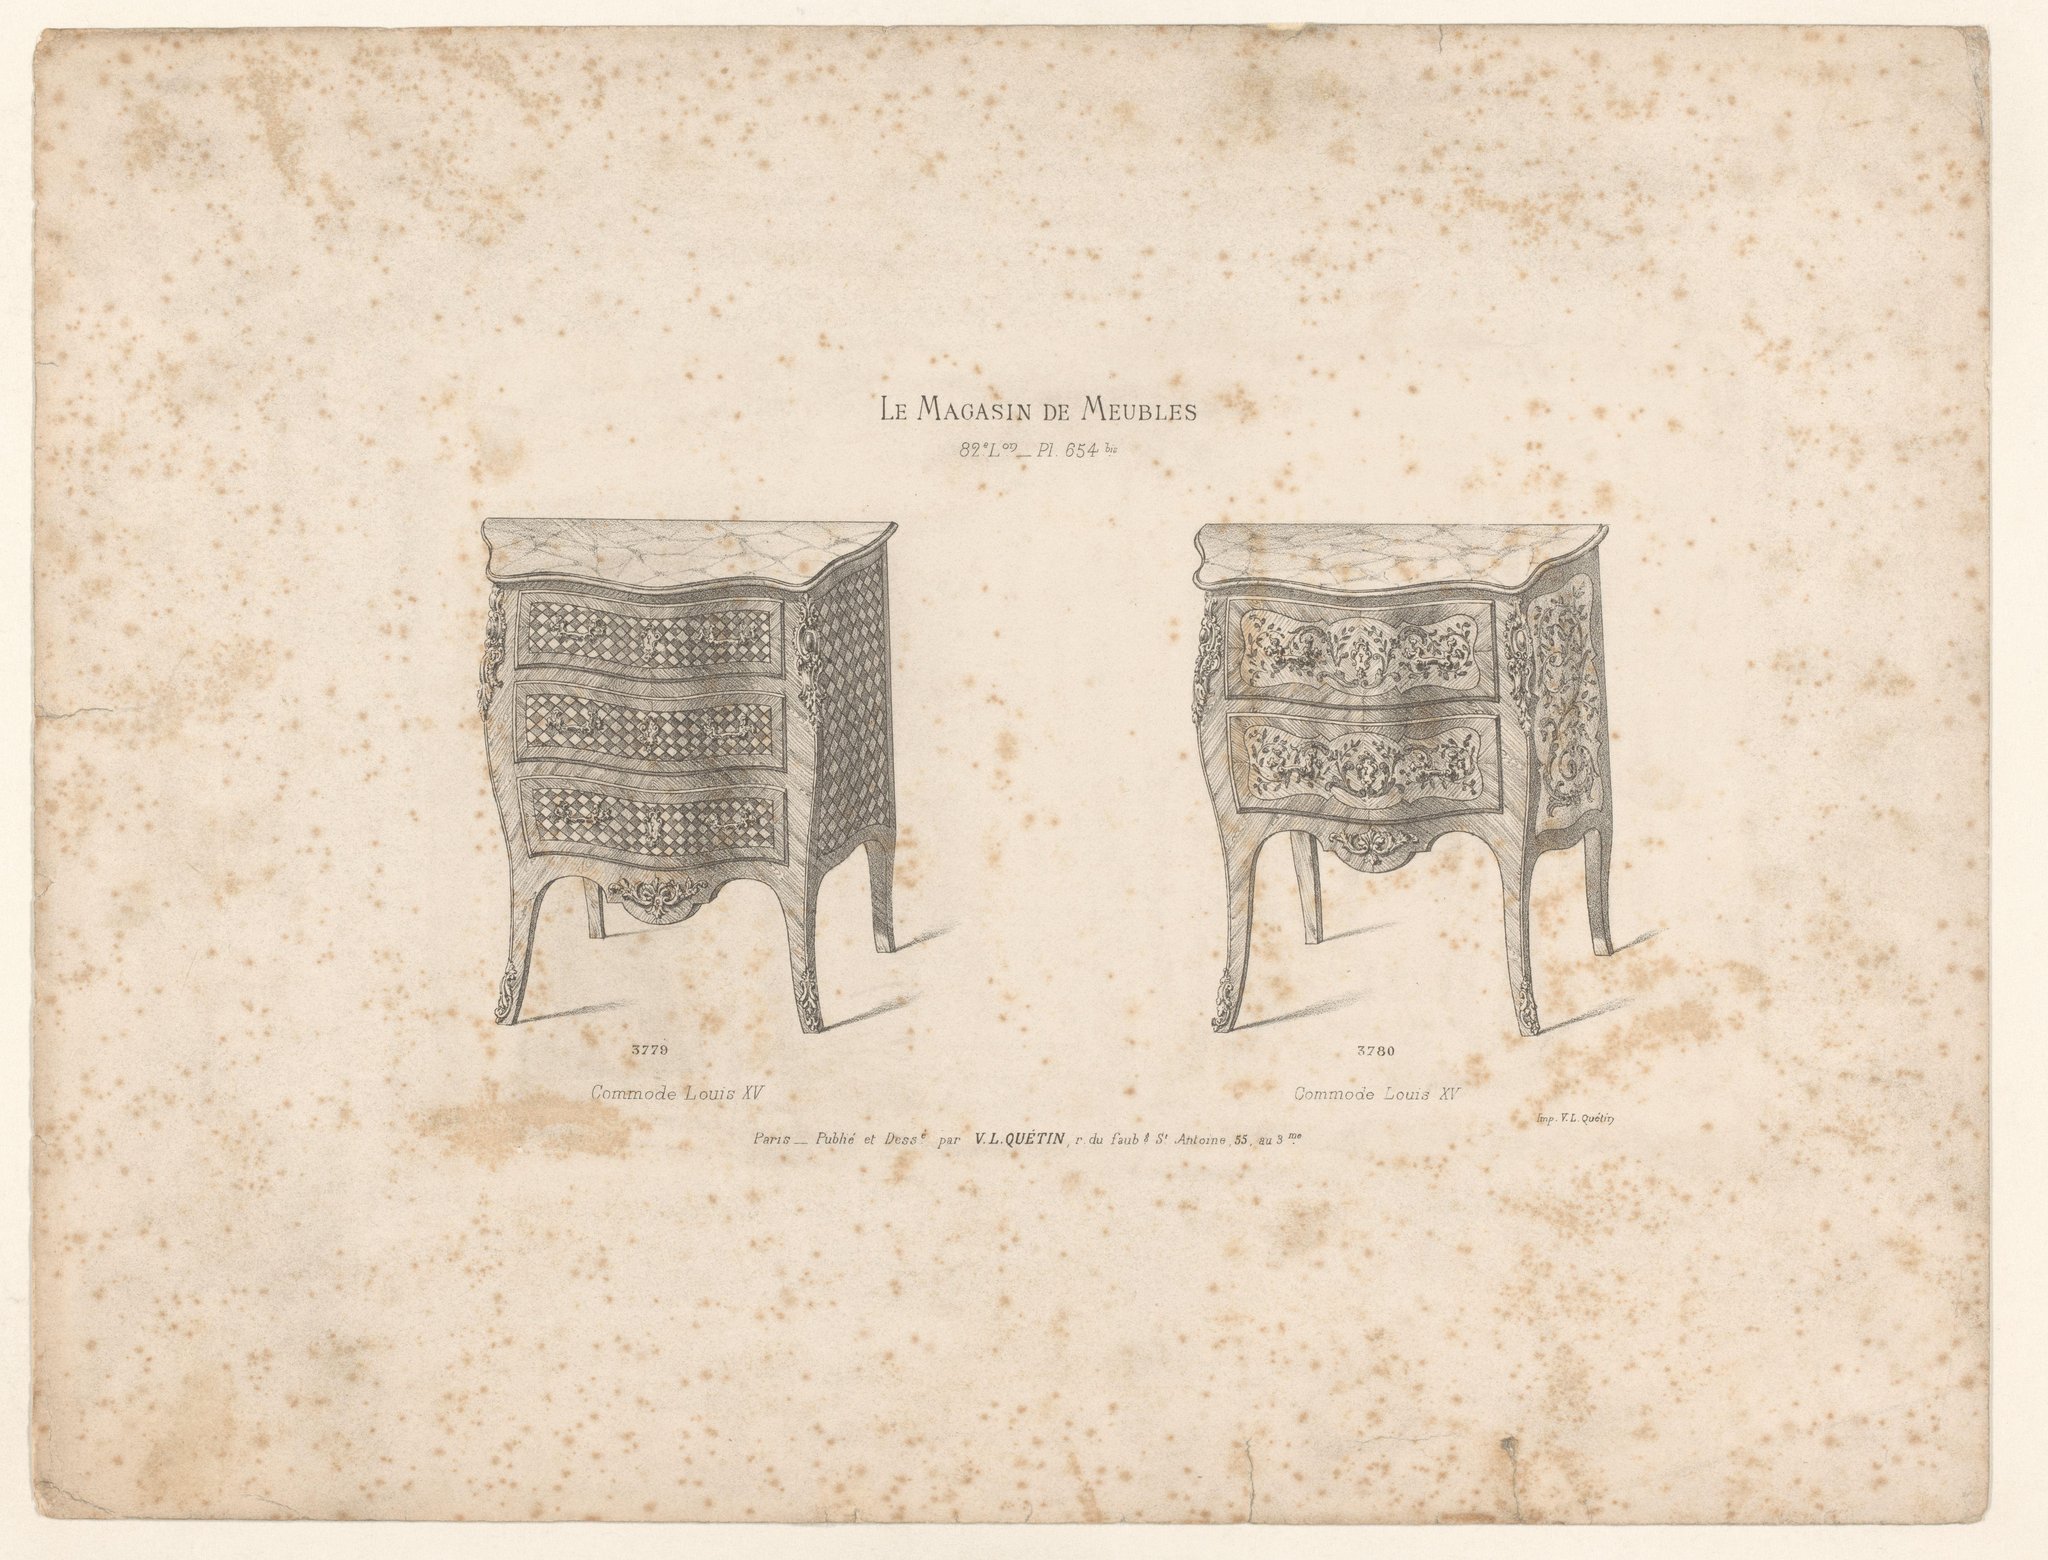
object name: print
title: Twee commodes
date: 1878-1904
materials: paper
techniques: lithograph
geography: paris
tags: furniture for storage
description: Twee commodes in de Lodewijk XV-stijl. Prent uit 82e Livraison.